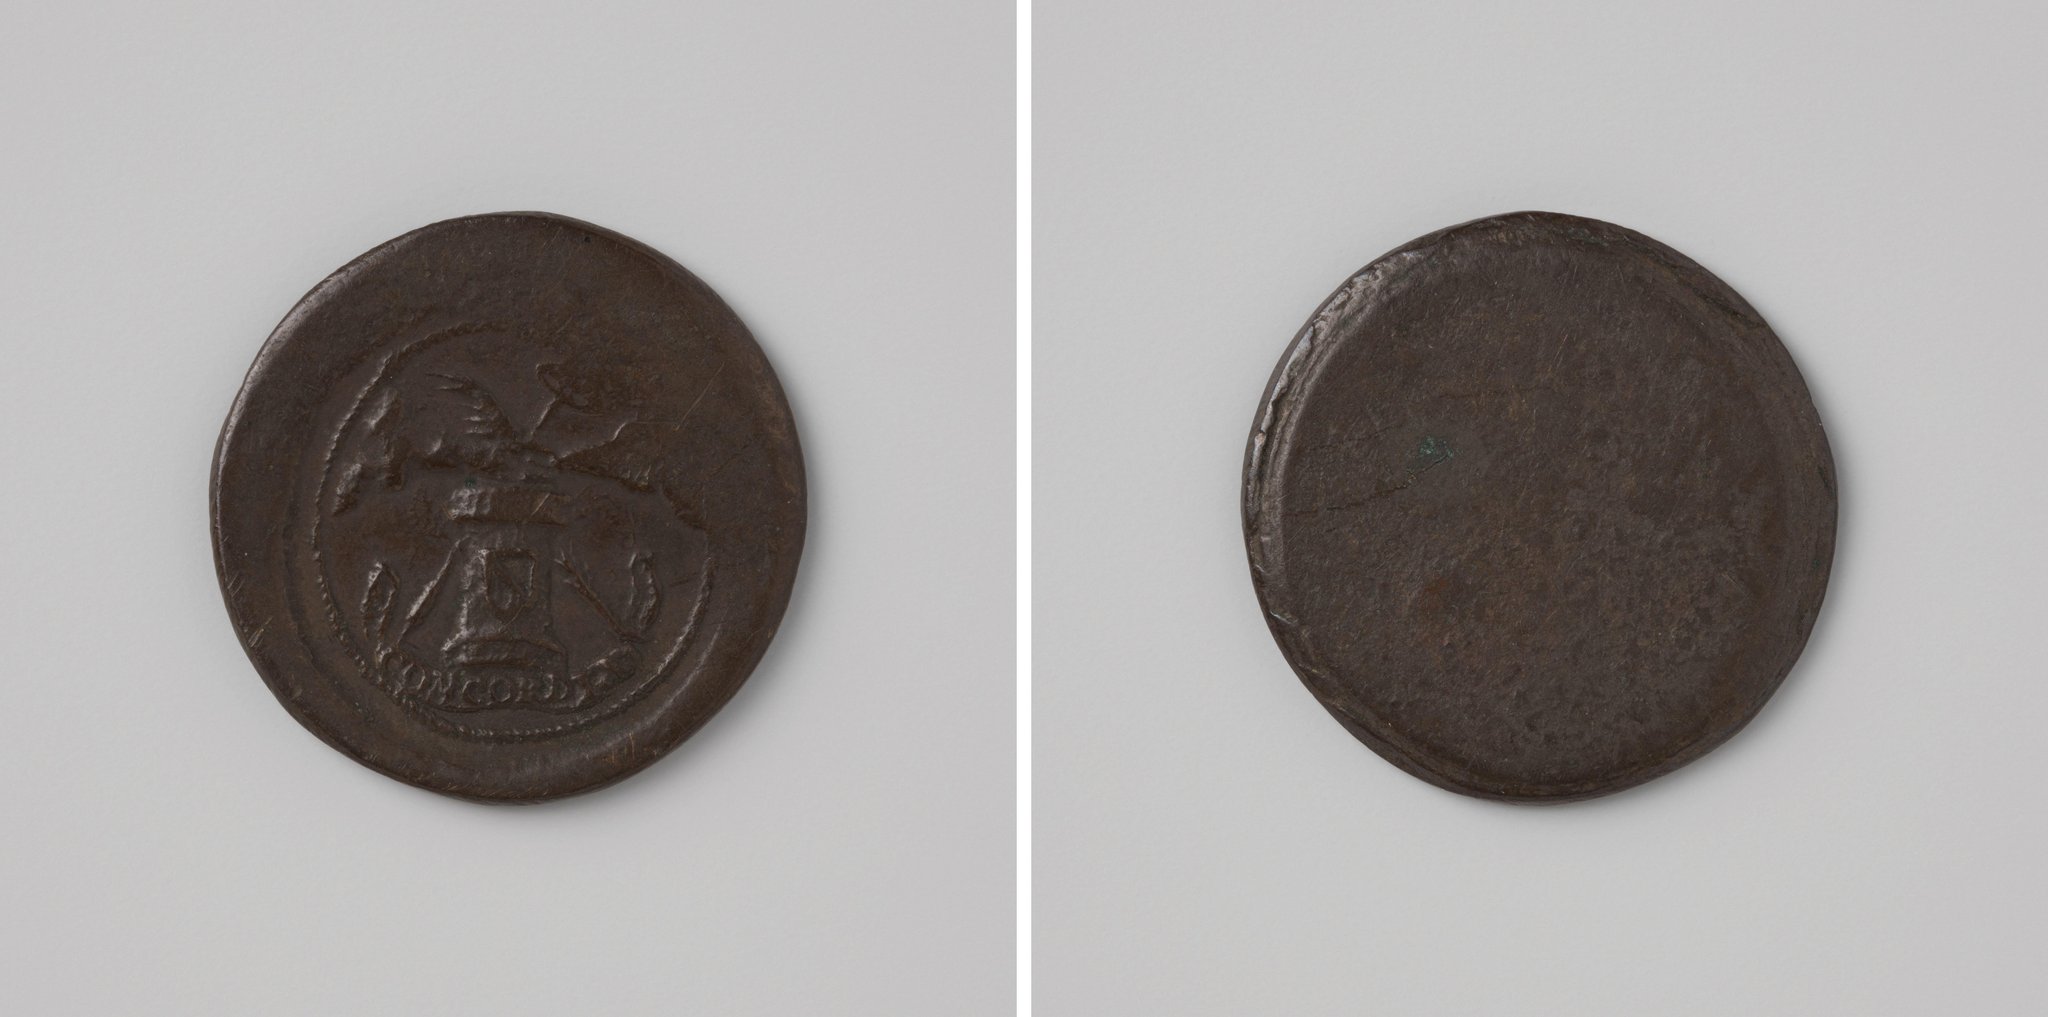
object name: presentiepenning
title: Provincie Utrecht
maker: Anonymous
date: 1784-1787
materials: copper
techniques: striking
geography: utrecht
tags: utrecht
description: Eenzijdige koperen penning. Voorzijde: twee ineengeslagen handen, een palmtak en vredesmuts op speer boven altaar met wapenschild op basis; daaronder wimpel met oschrift. Keerzijde: blanco